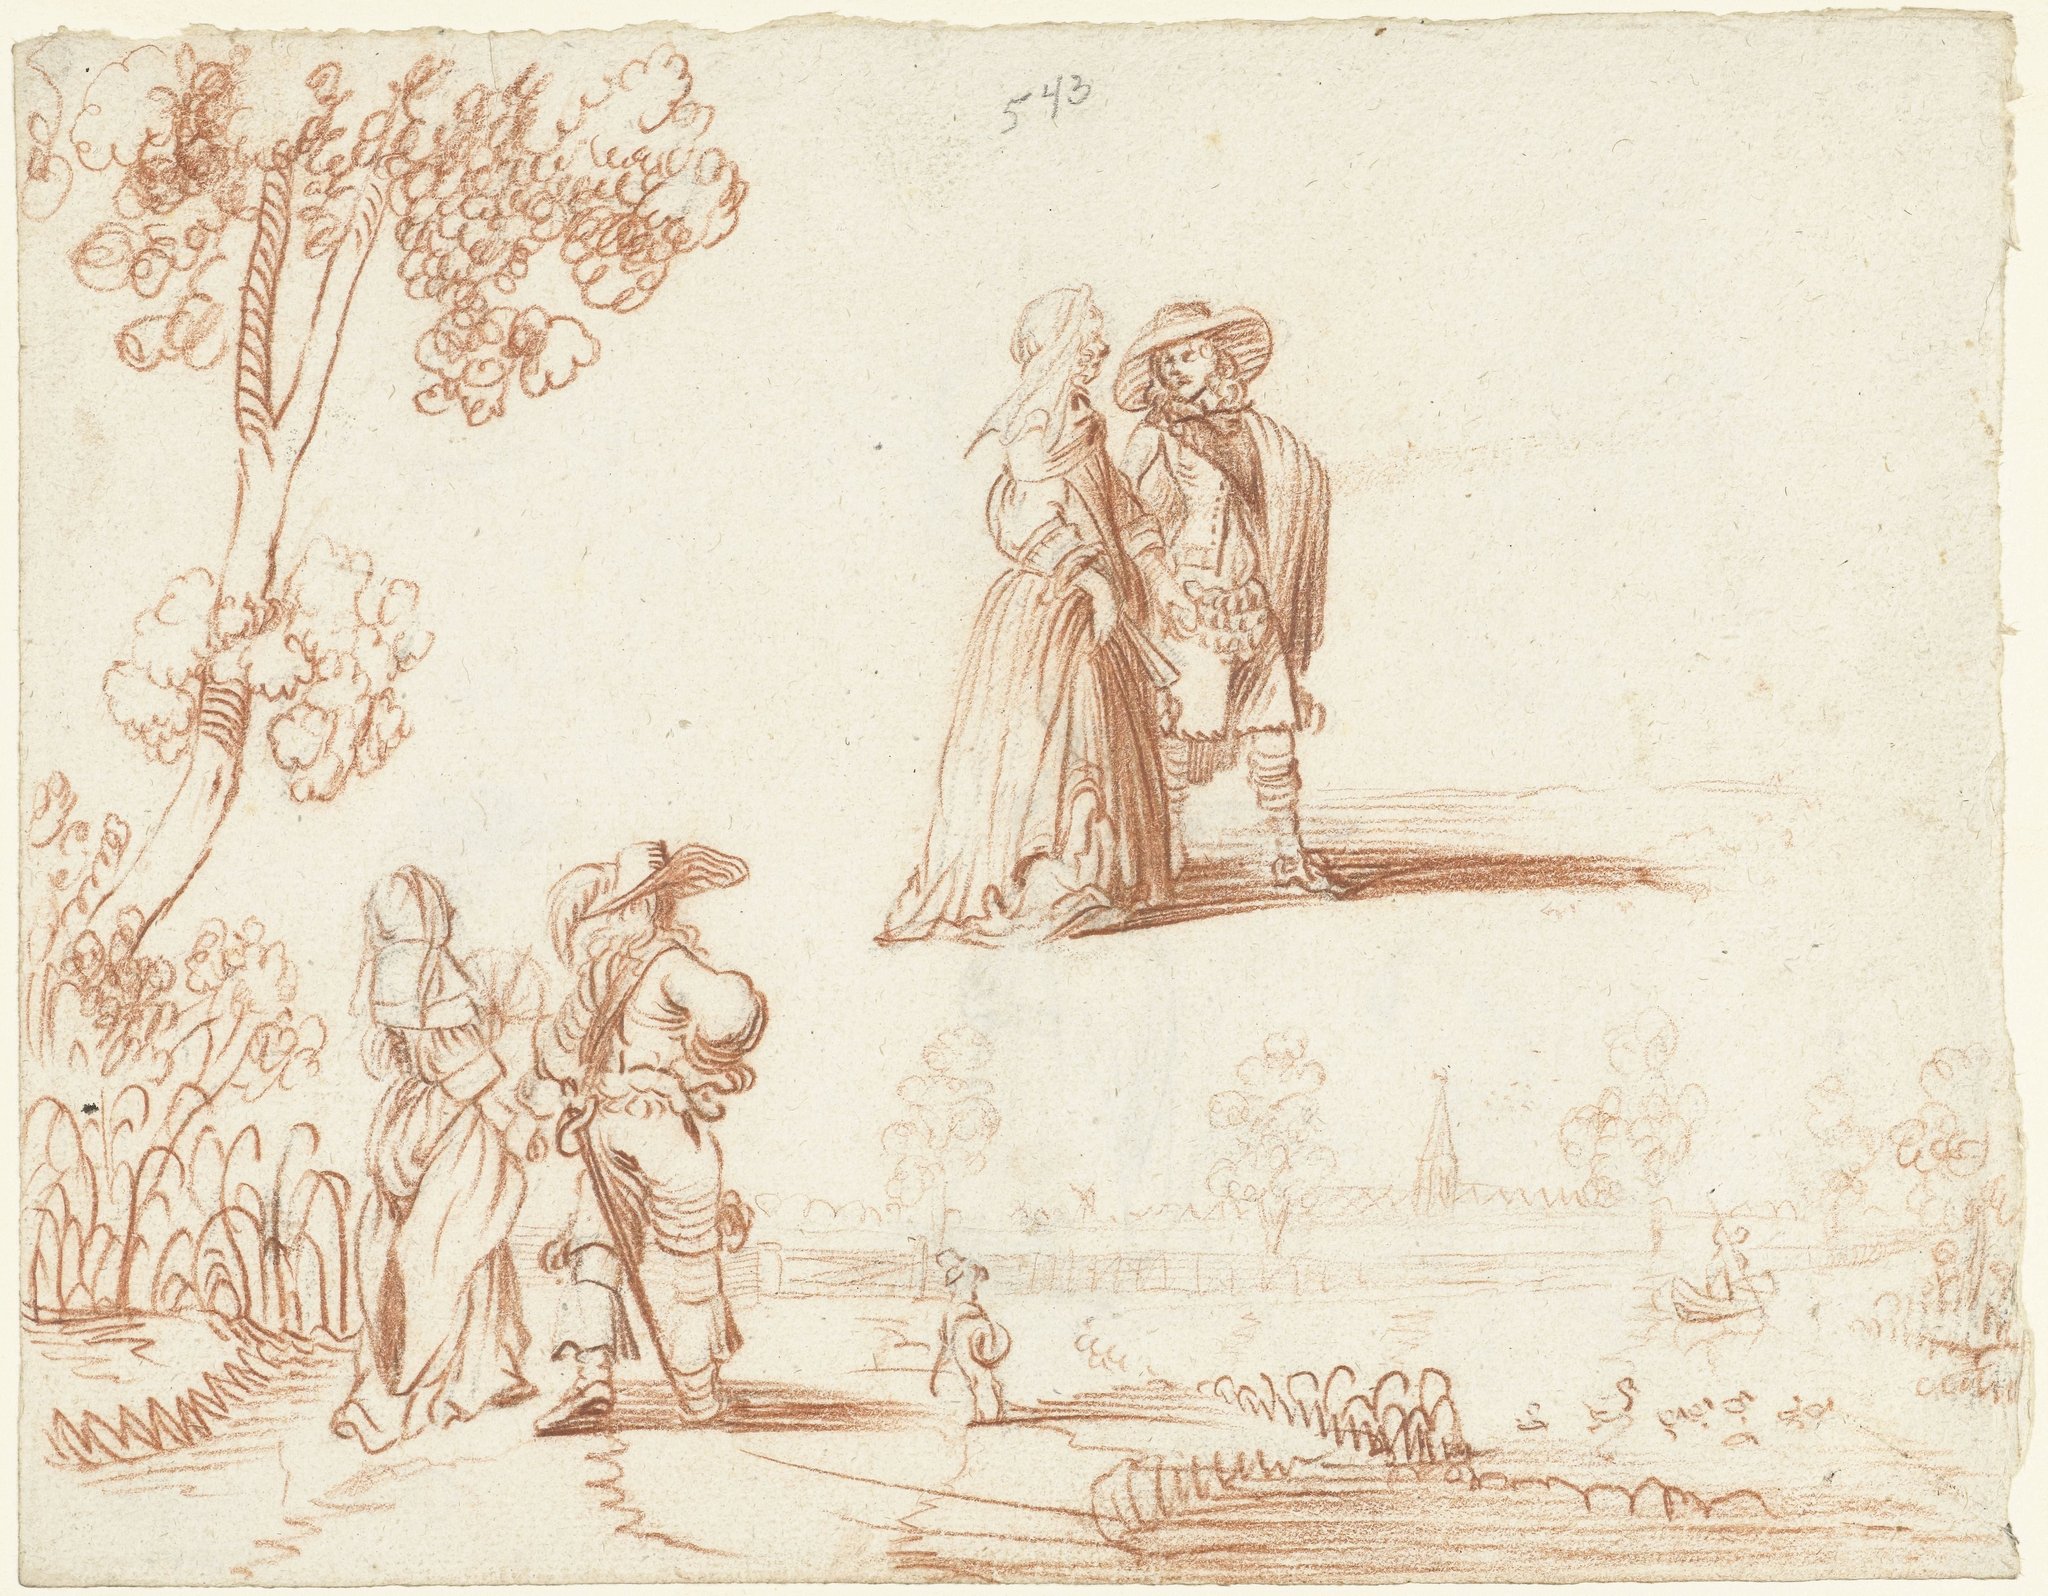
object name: drawing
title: Twee paartjes lopend naast een kanaal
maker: gesina ter borch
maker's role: draughtsman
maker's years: 1633-1690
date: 1661-1669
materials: chalk, paper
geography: zwolle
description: Studieblad met twee paartjes lopend naast een kanaal.